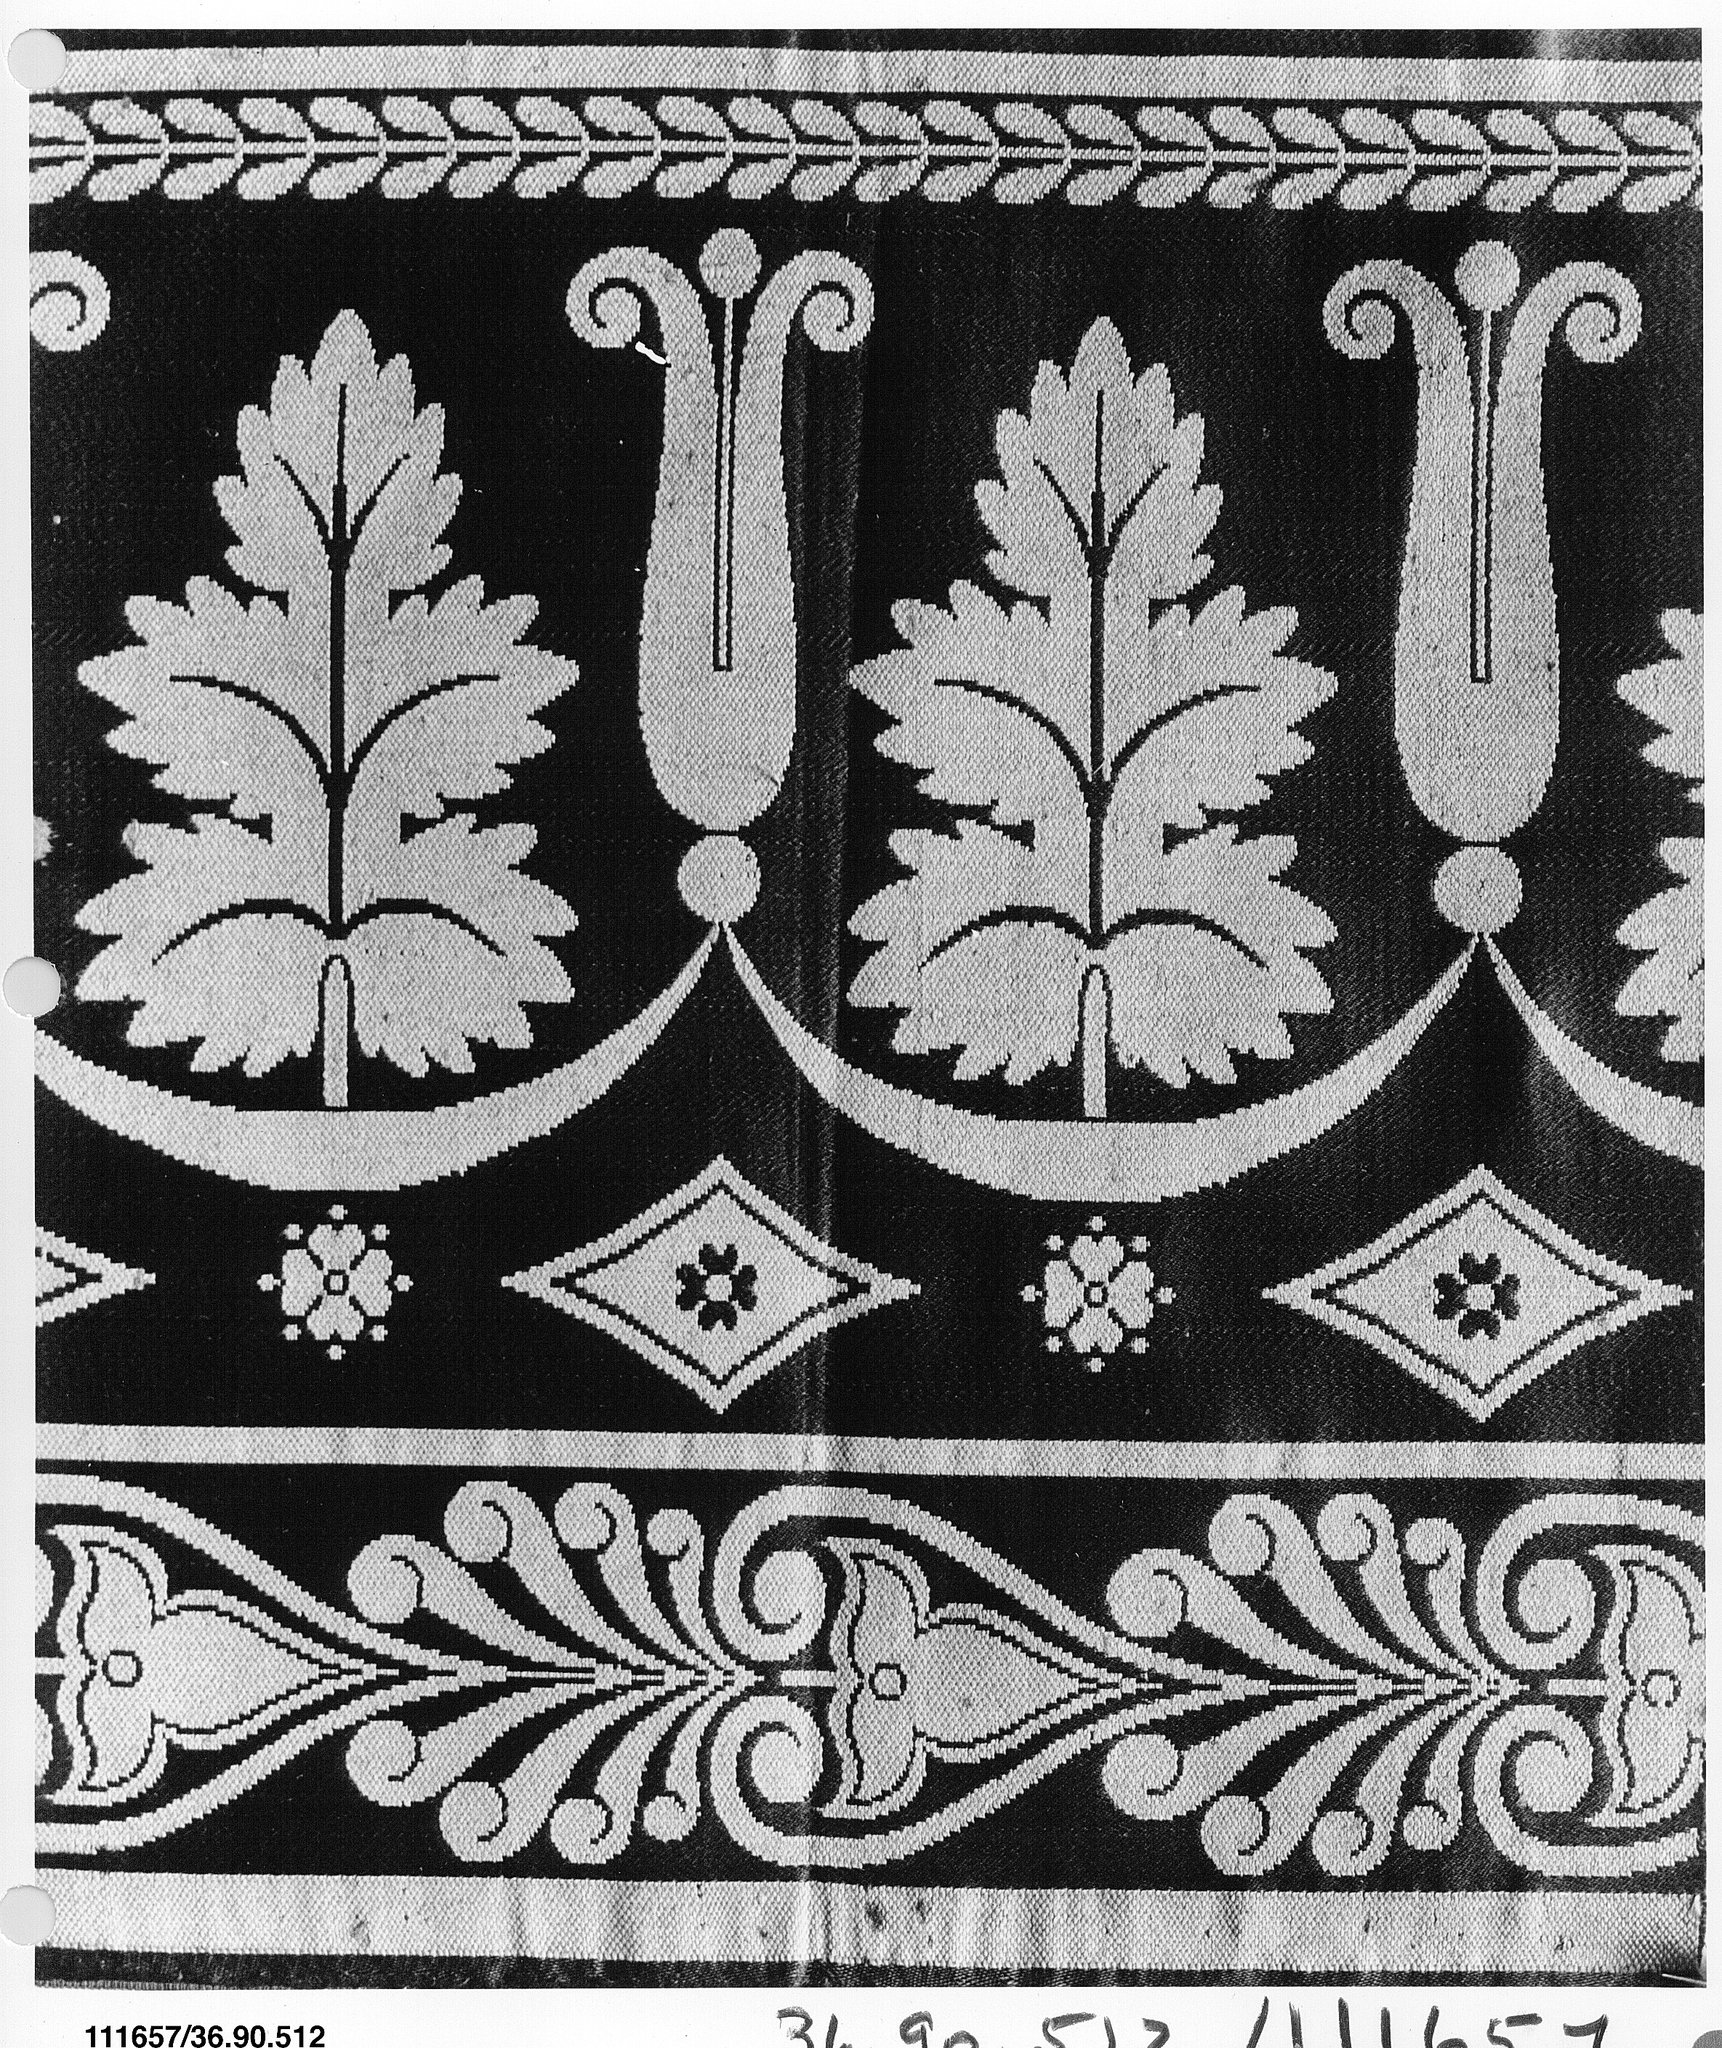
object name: piece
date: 1801-1833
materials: silk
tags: leaves